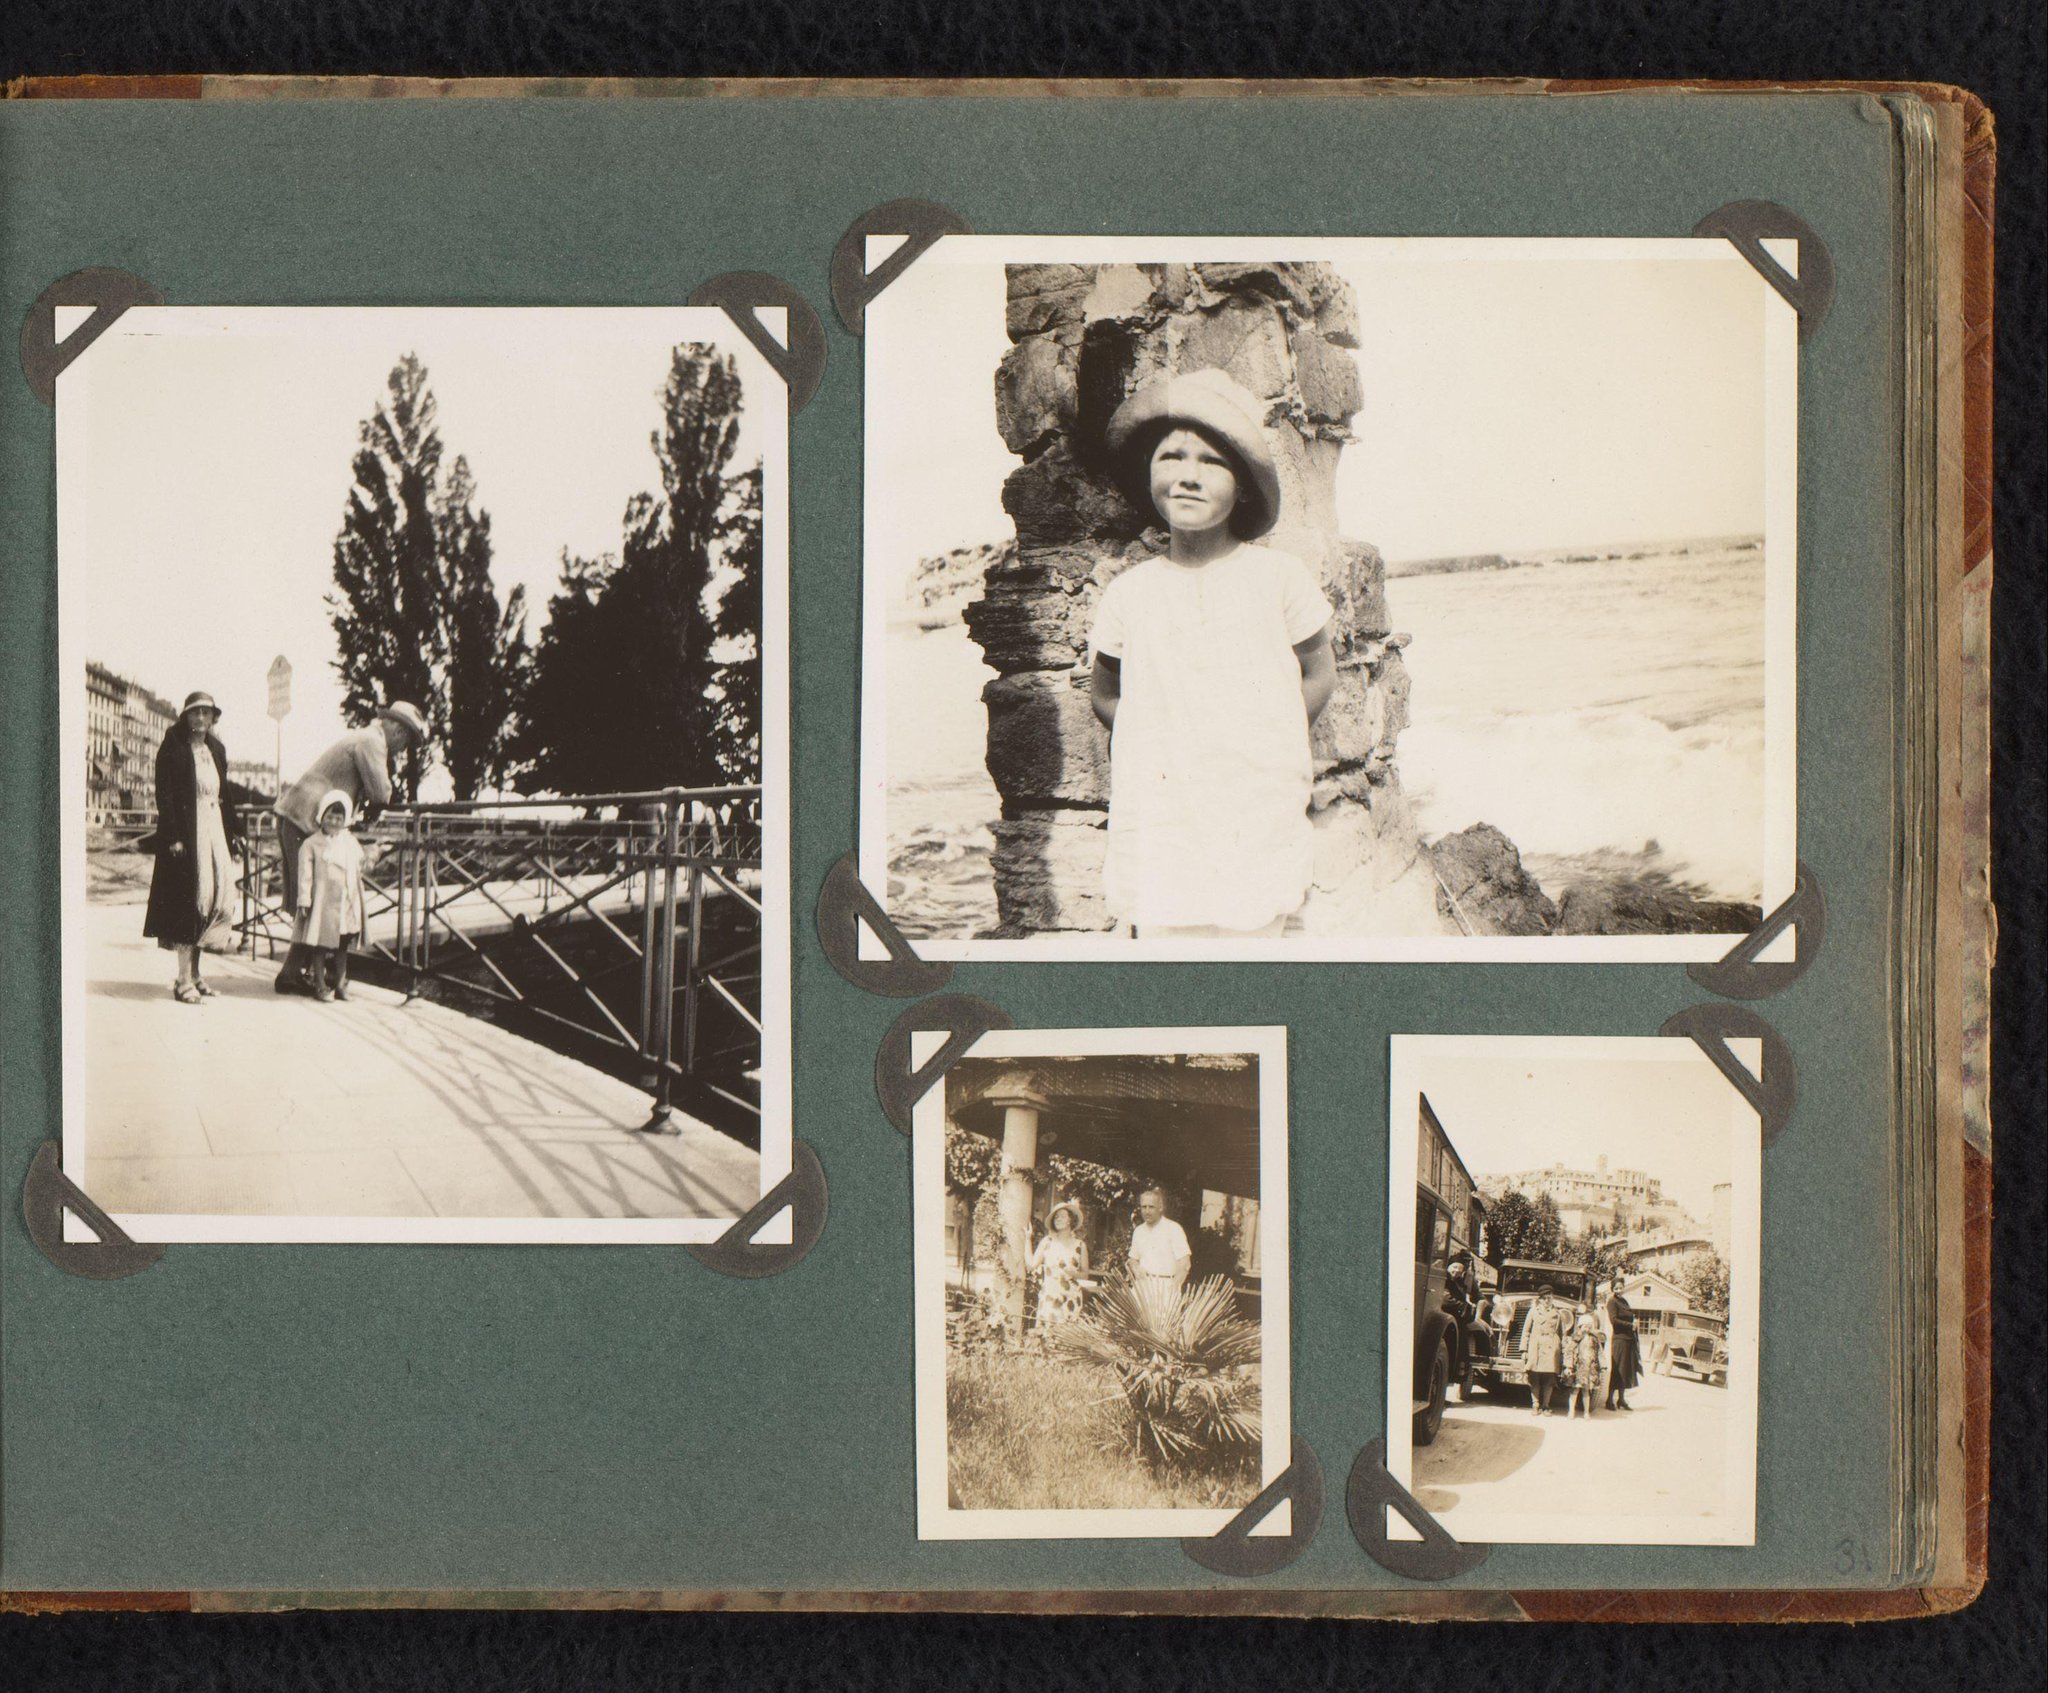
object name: photograph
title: Vier foto's van familie Onnen-Van den Berg tijdens een vakantie, mogelijk in Nice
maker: Anonymous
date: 1920-1930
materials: paper, cardboard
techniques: gelatin silver print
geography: france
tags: the family travelling, on holiday, avenue, boulevard, promenade, esplanade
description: Deze foto's maken deel uit van een album.